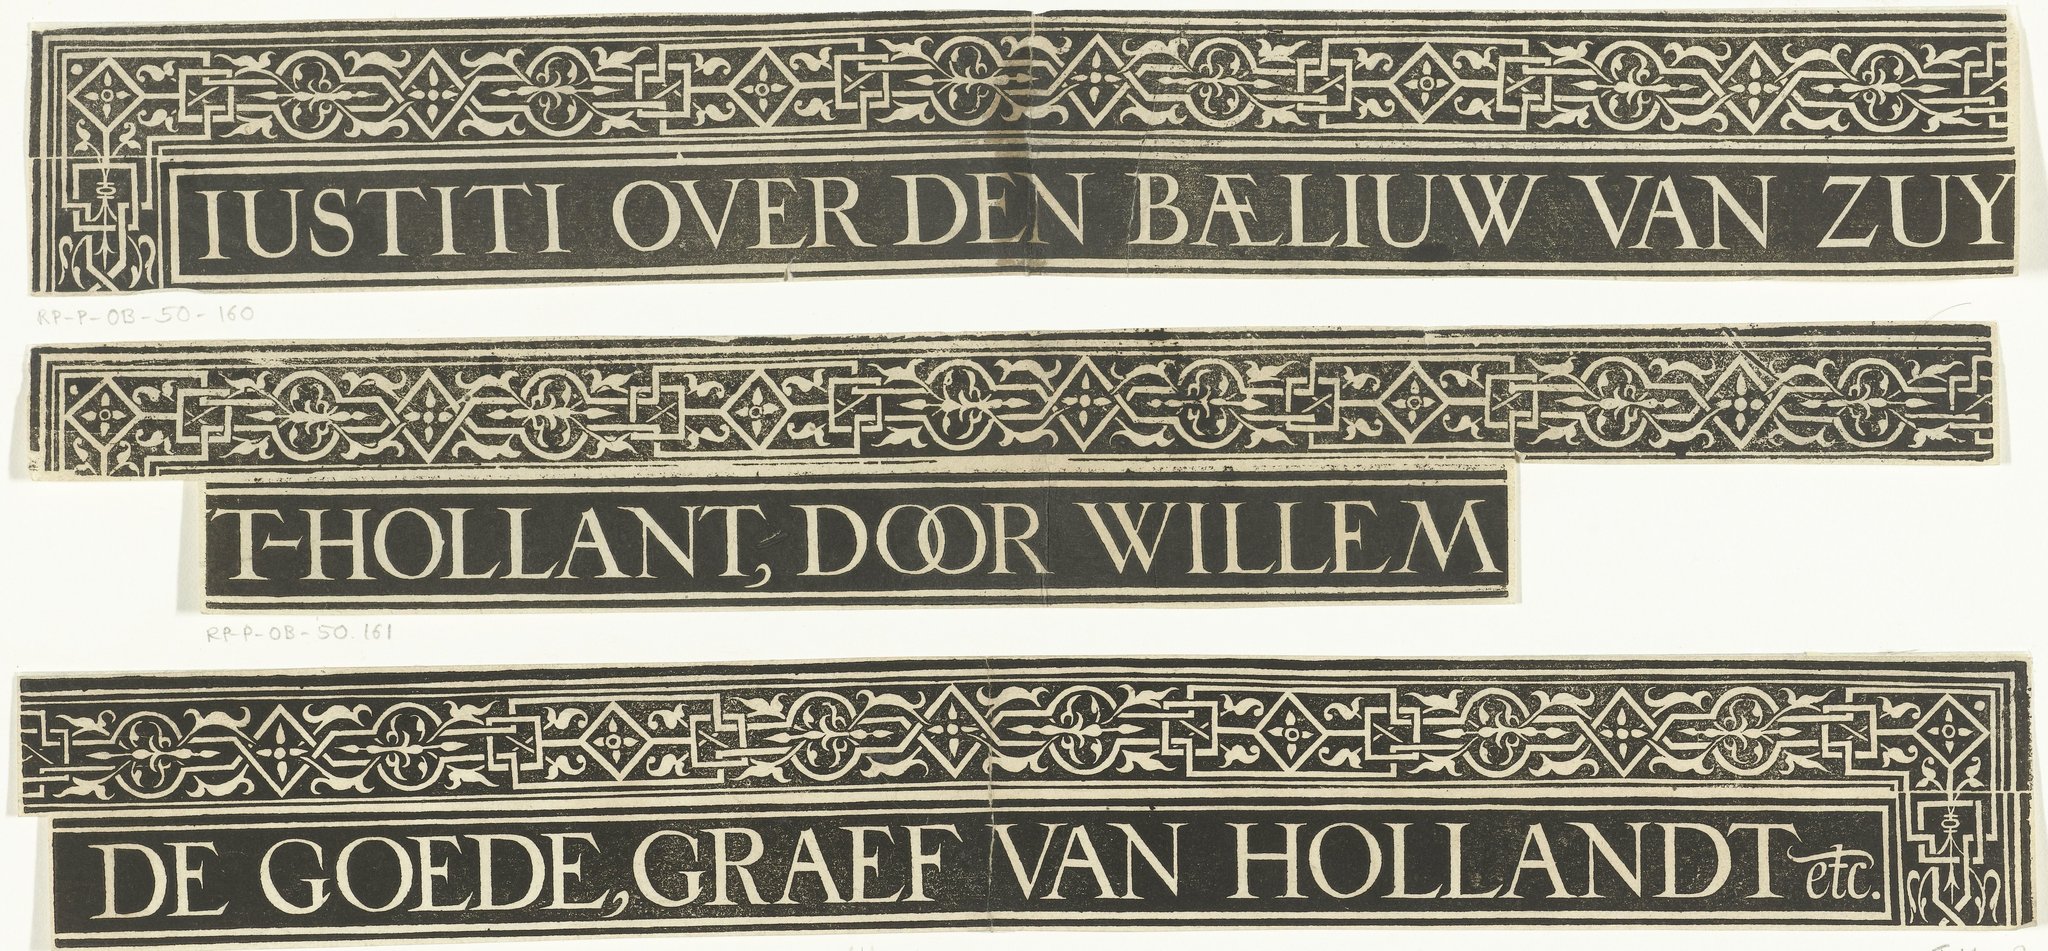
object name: print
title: Iustiti over den baeliuw van Zuyt-Hollant, door Willem de Goede, graef van Hollandt etc.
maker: Anonymous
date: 1613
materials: paper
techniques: woodcut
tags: willem iii de goede (graaf van holland en henegouwen)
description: Ornamentale rand met titel. Derde van drie stroken tekst. Oorspronkelijk stond deze titel boven de grote centrale voorstelling in de prent van het verhaal van de Rechtspraak van graaf Willem III in het jaar 1336.